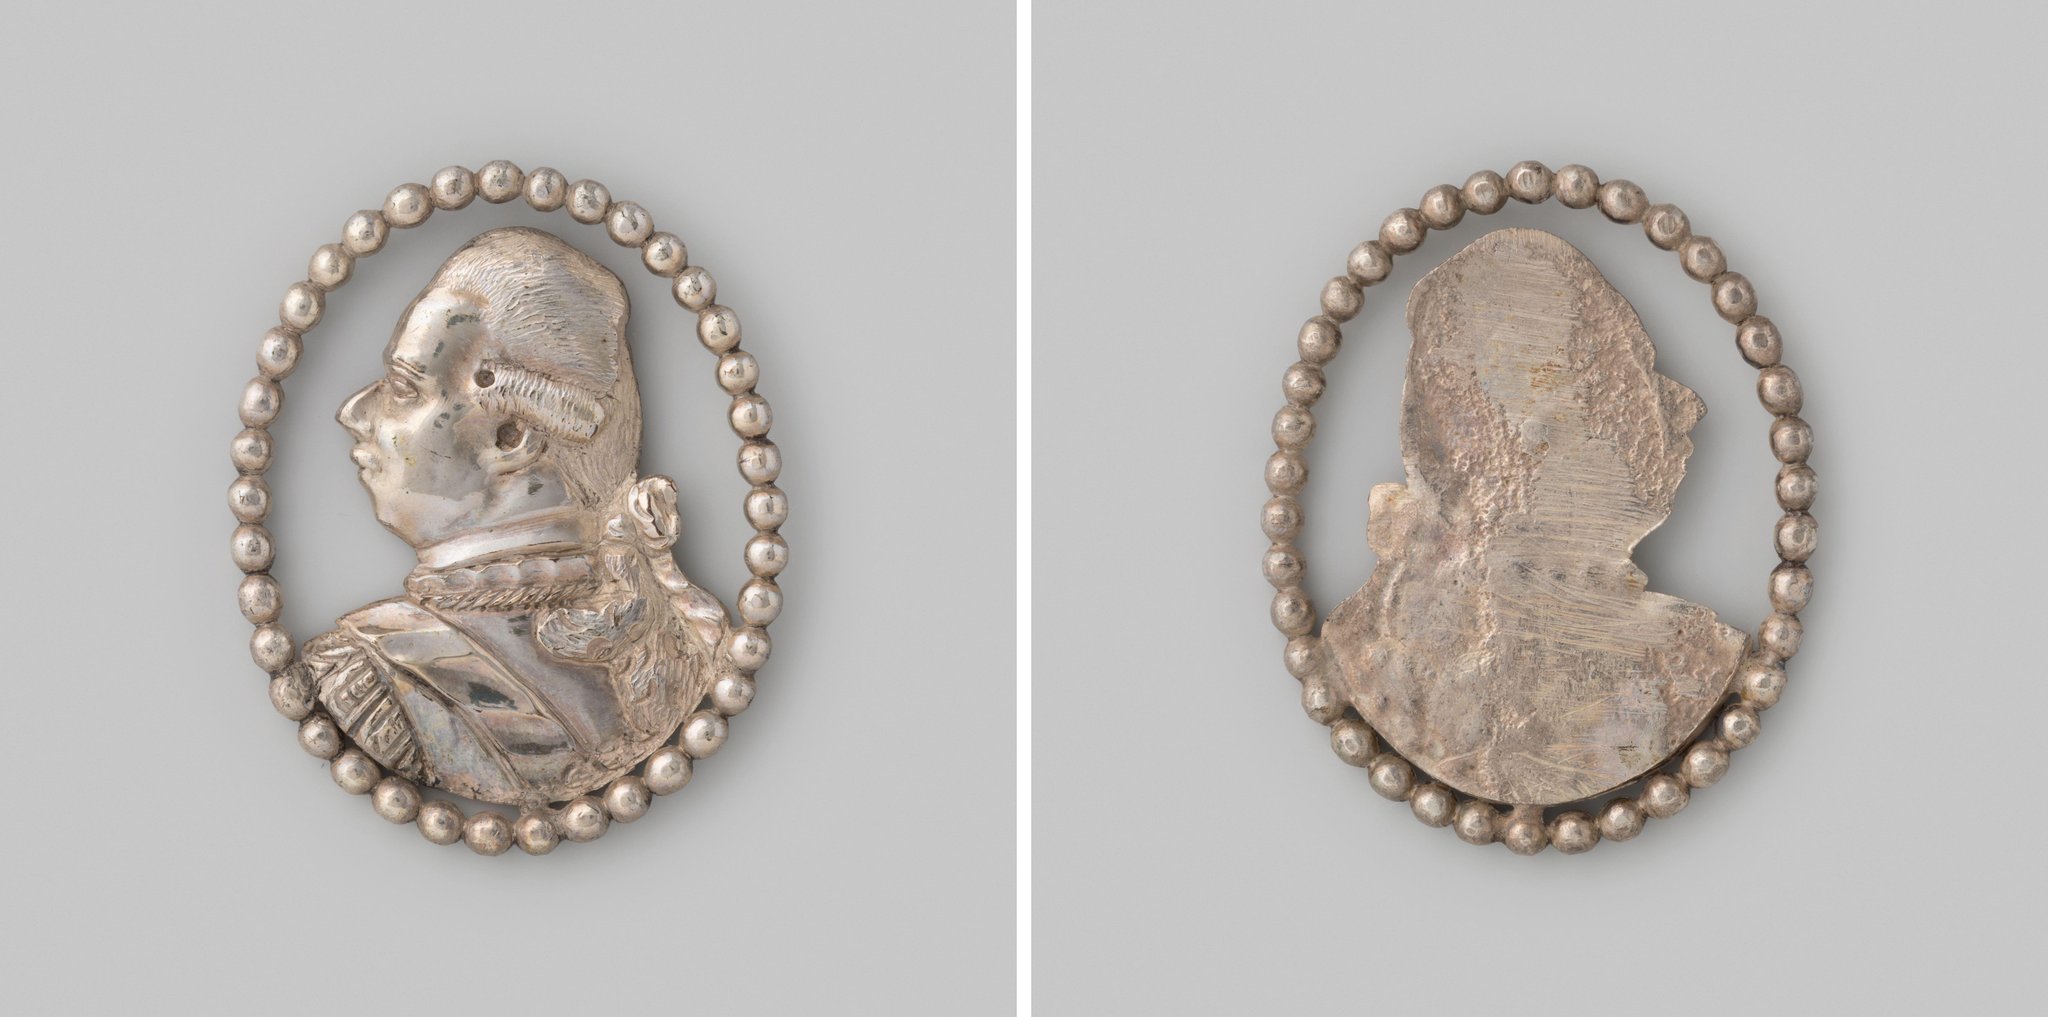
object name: insignia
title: Willem V, prins van Oranje-Nassau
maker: Anonymous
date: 1787-1795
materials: silver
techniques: embroidery, striking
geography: netherlands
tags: the hague, william v (prince of orange)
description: Eenzijdig zilveren ovaal opengewerkt draagteken. Voorzijde: borststuk man binnen parelrand. Keerzijde: blanco